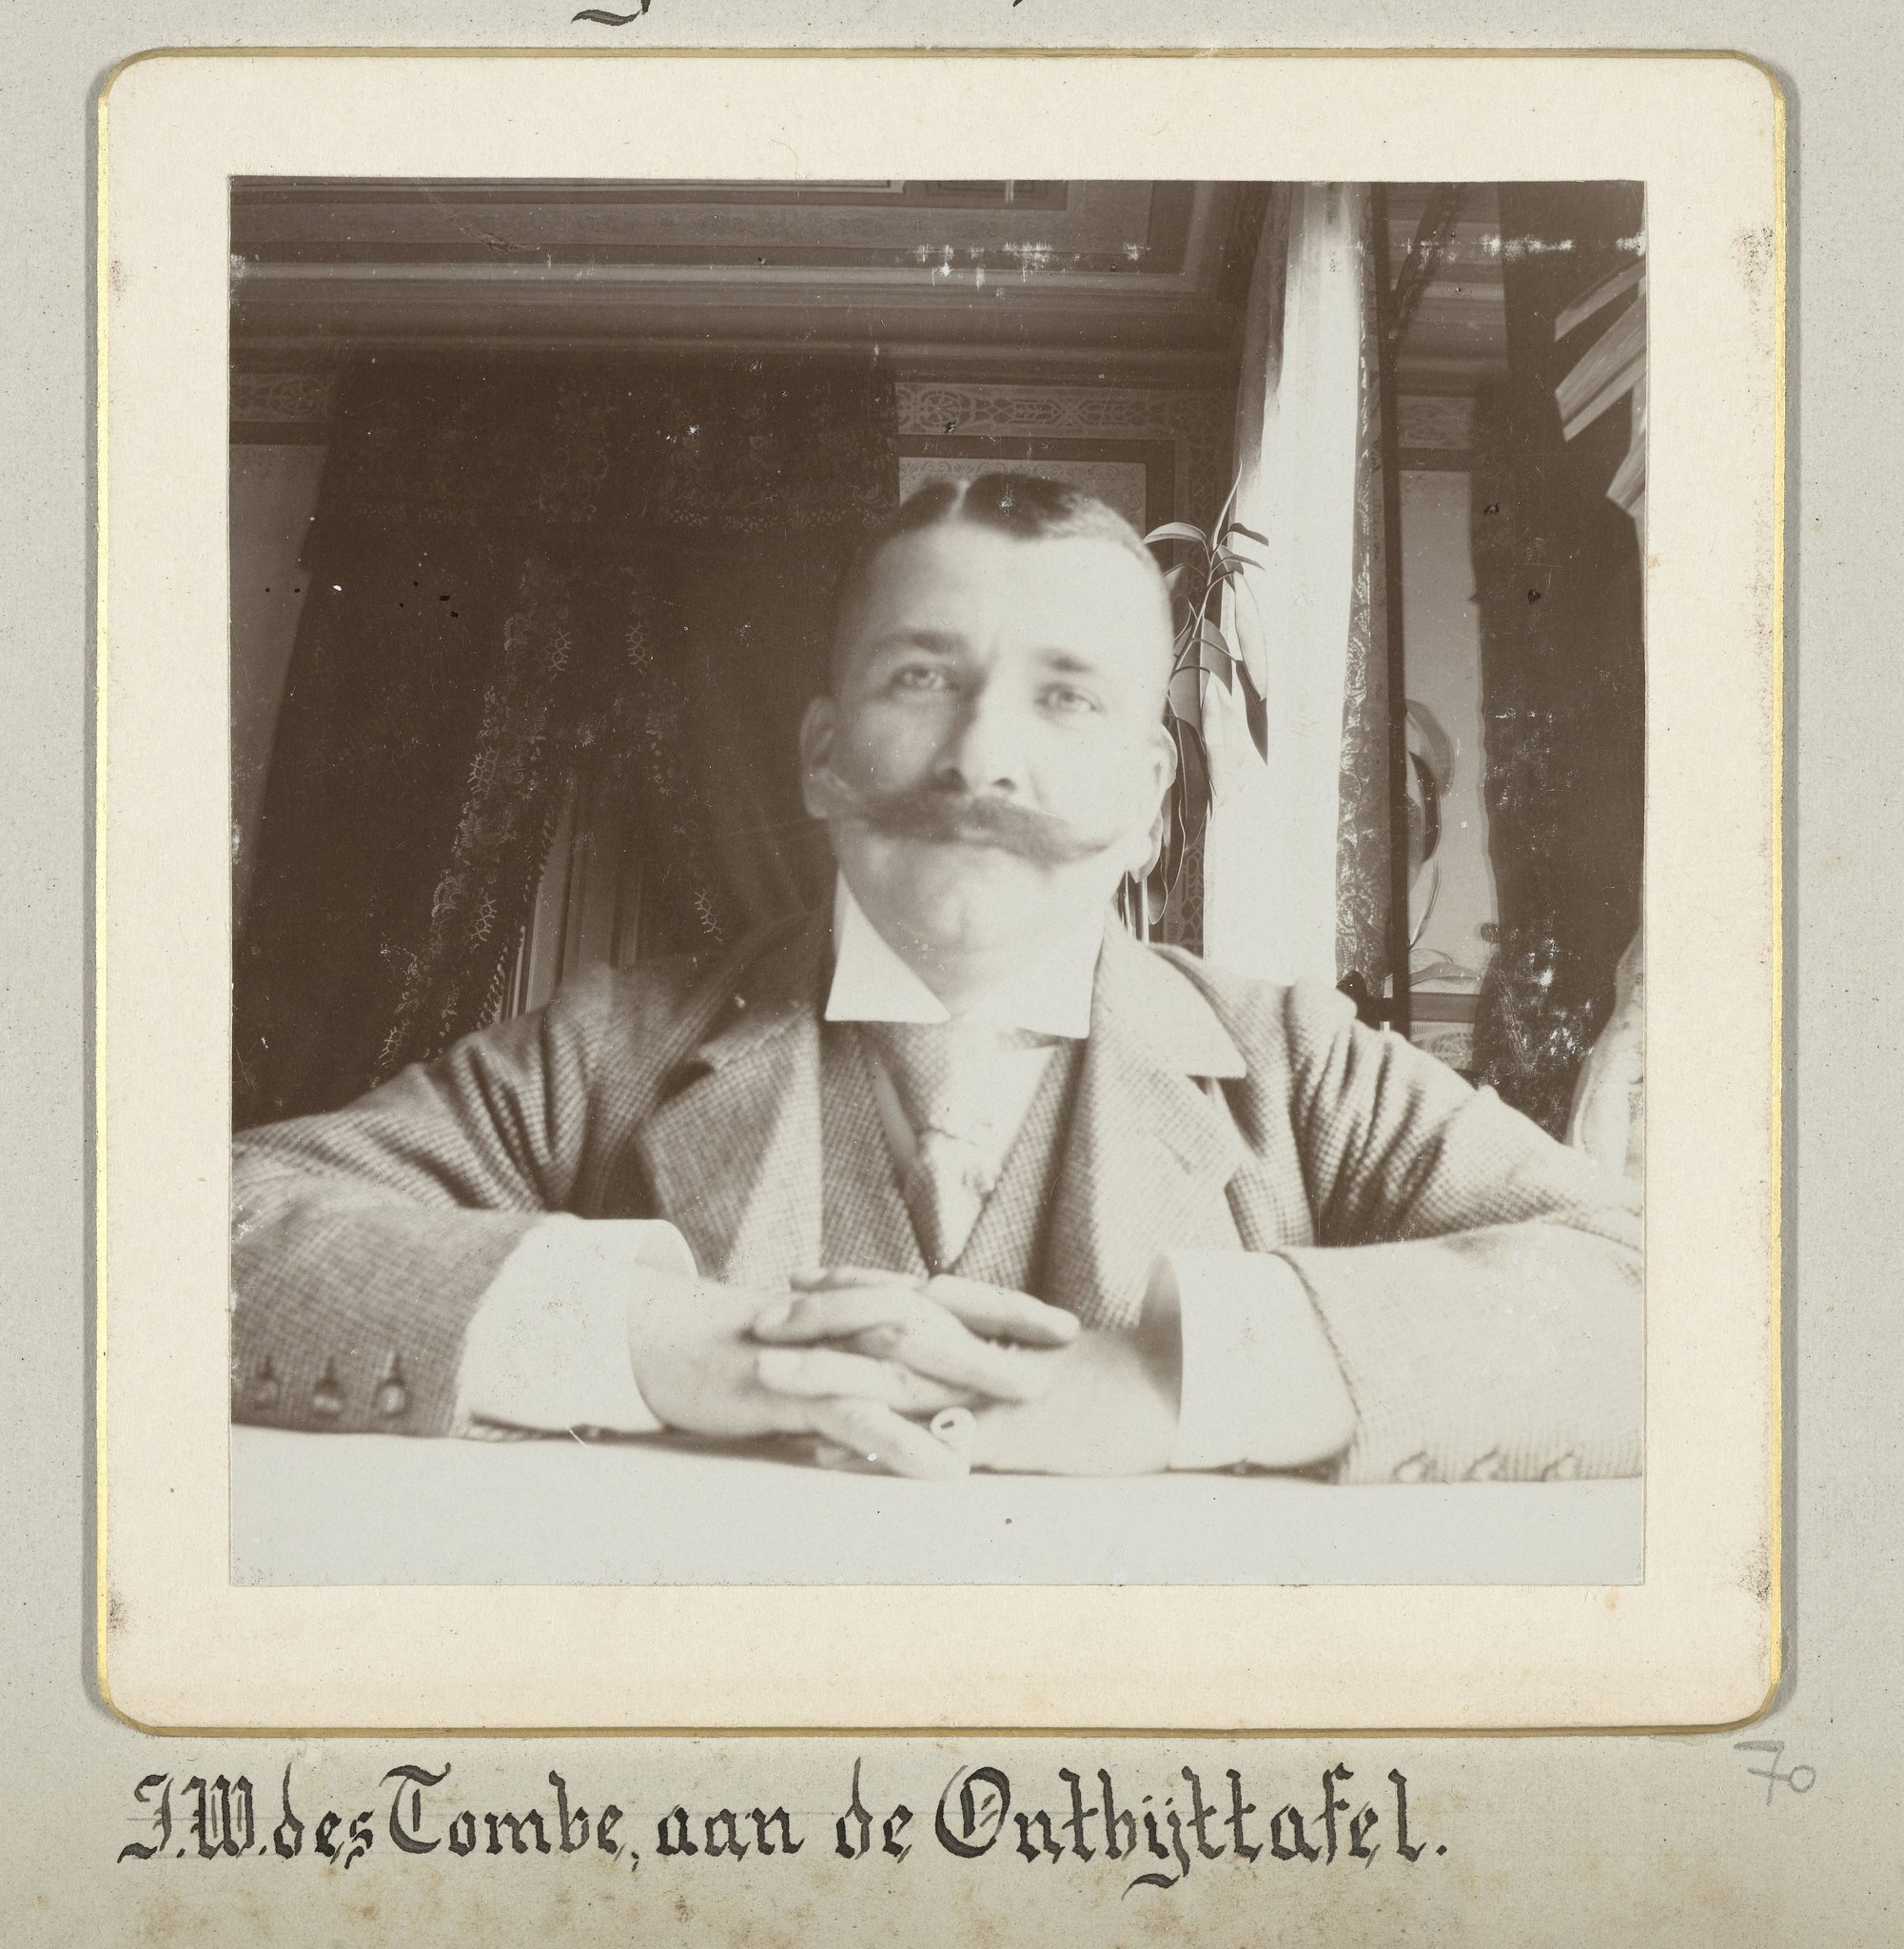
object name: photograph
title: J.W. des Tombe, aan de Ontbijttafel in Lappeenranta, Finland.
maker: henry pauw van wieldrecht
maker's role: fotograaf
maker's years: 1863-1912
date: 1898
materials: paper, photographic support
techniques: albumen print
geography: netherlands